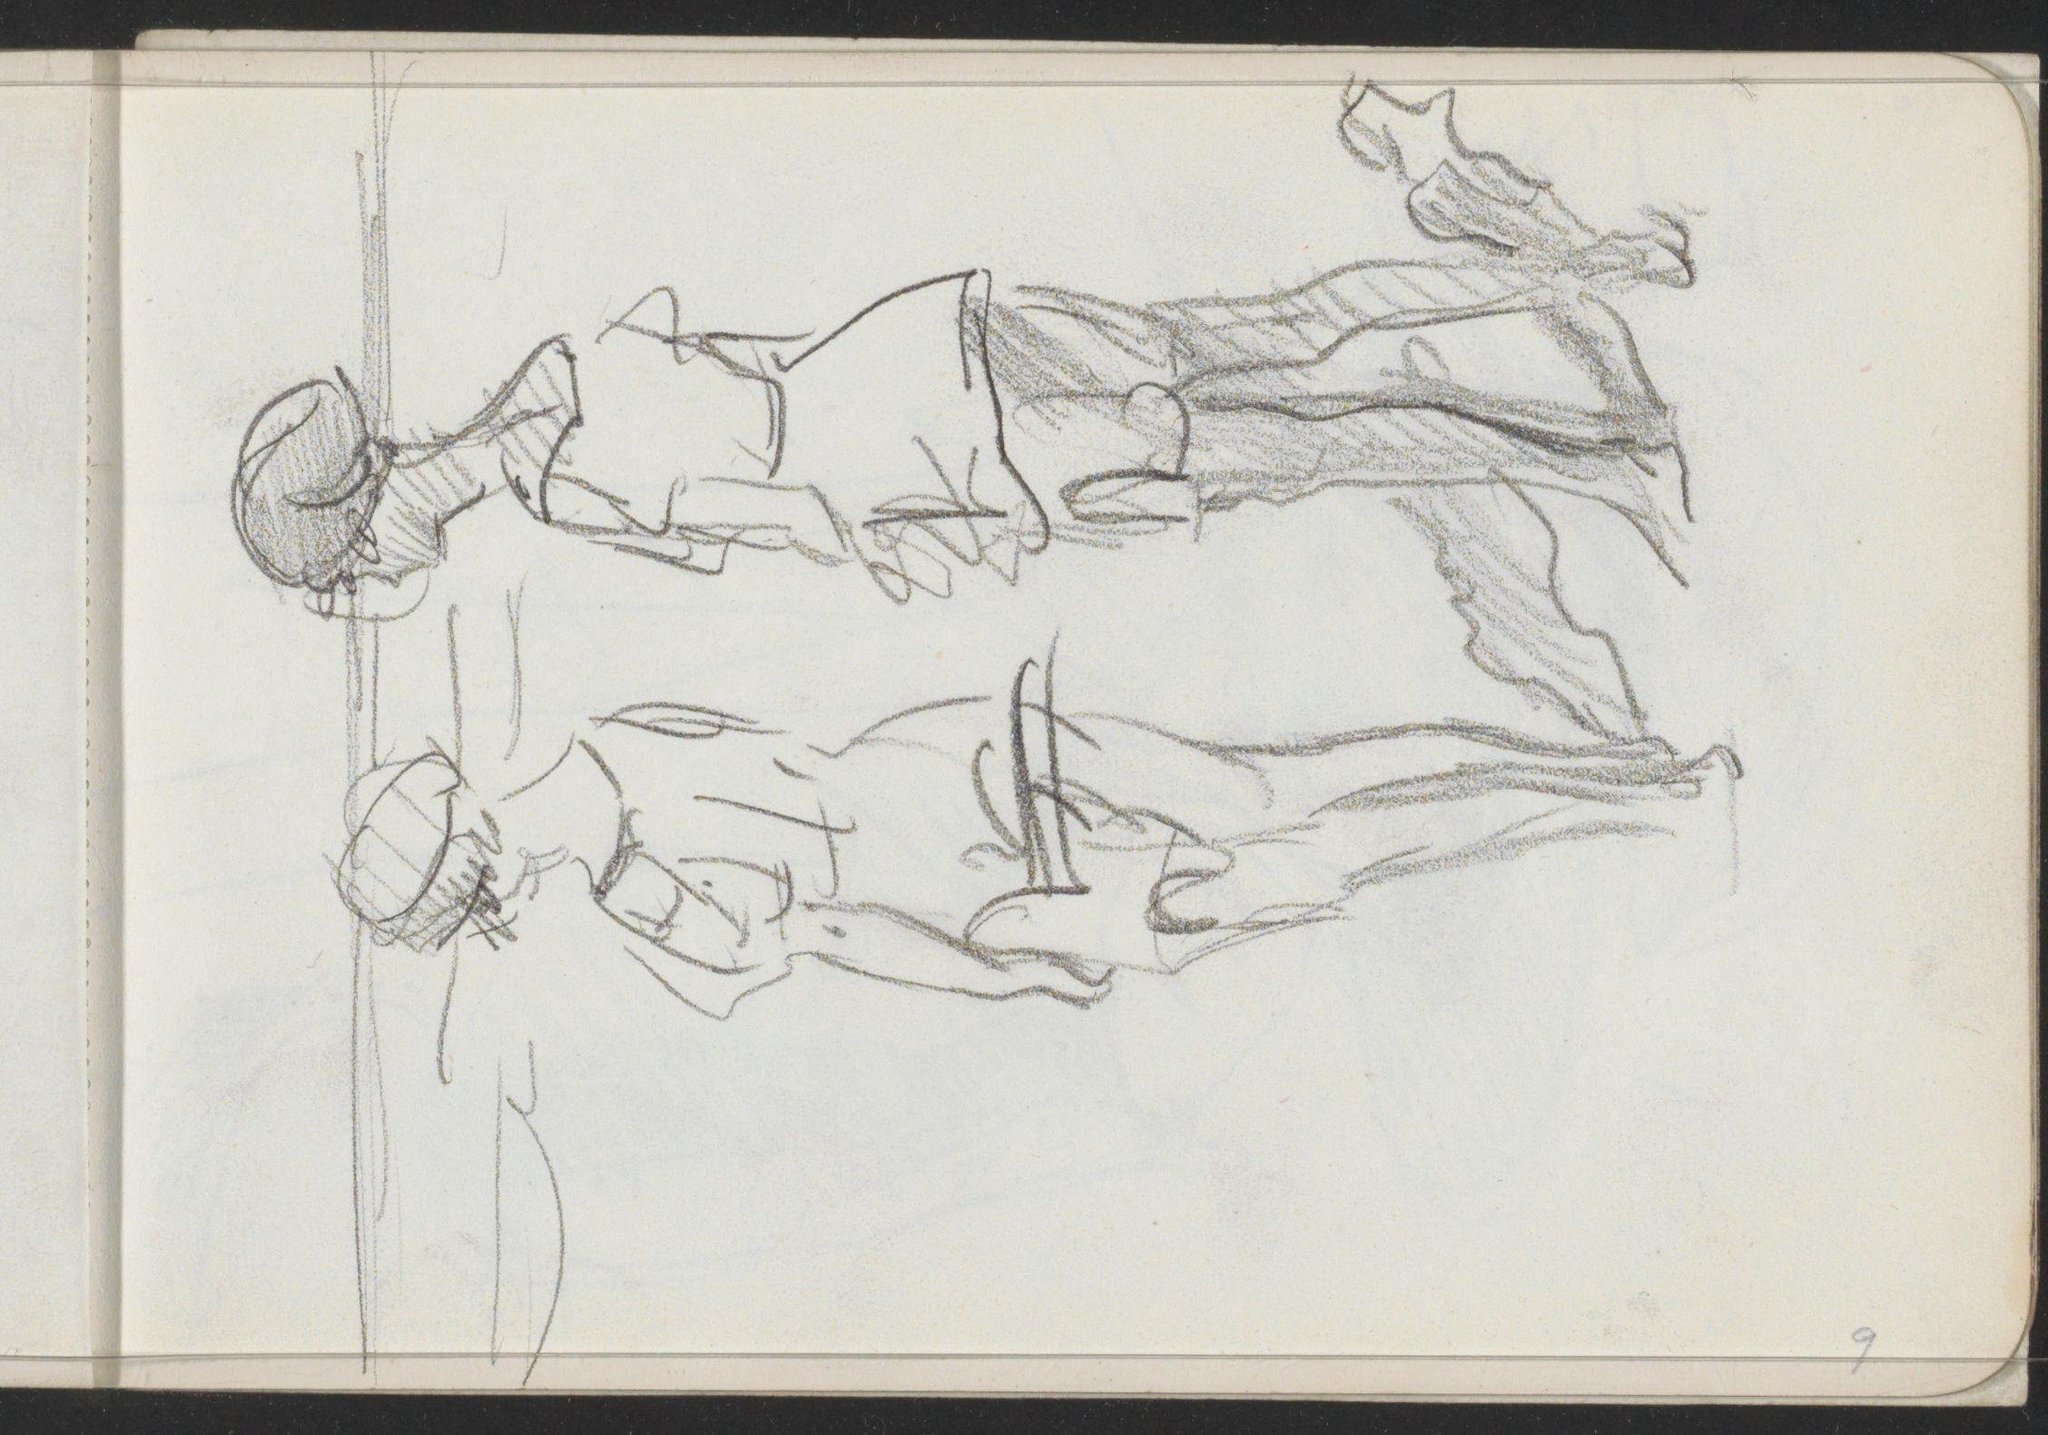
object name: sketchbook leaf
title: Twee jongen vrouwen in badkleding op het strand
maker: isaac israels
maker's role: draughtsman, painter, print maker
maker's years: 1865-1934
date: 1875-1934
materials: paper, pencil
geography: the hague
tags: beach (as place of recreation), adolescent, young woman, maiden (+ standing)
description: Blad 9 recto uit schetsboek LX met 33 bladen.